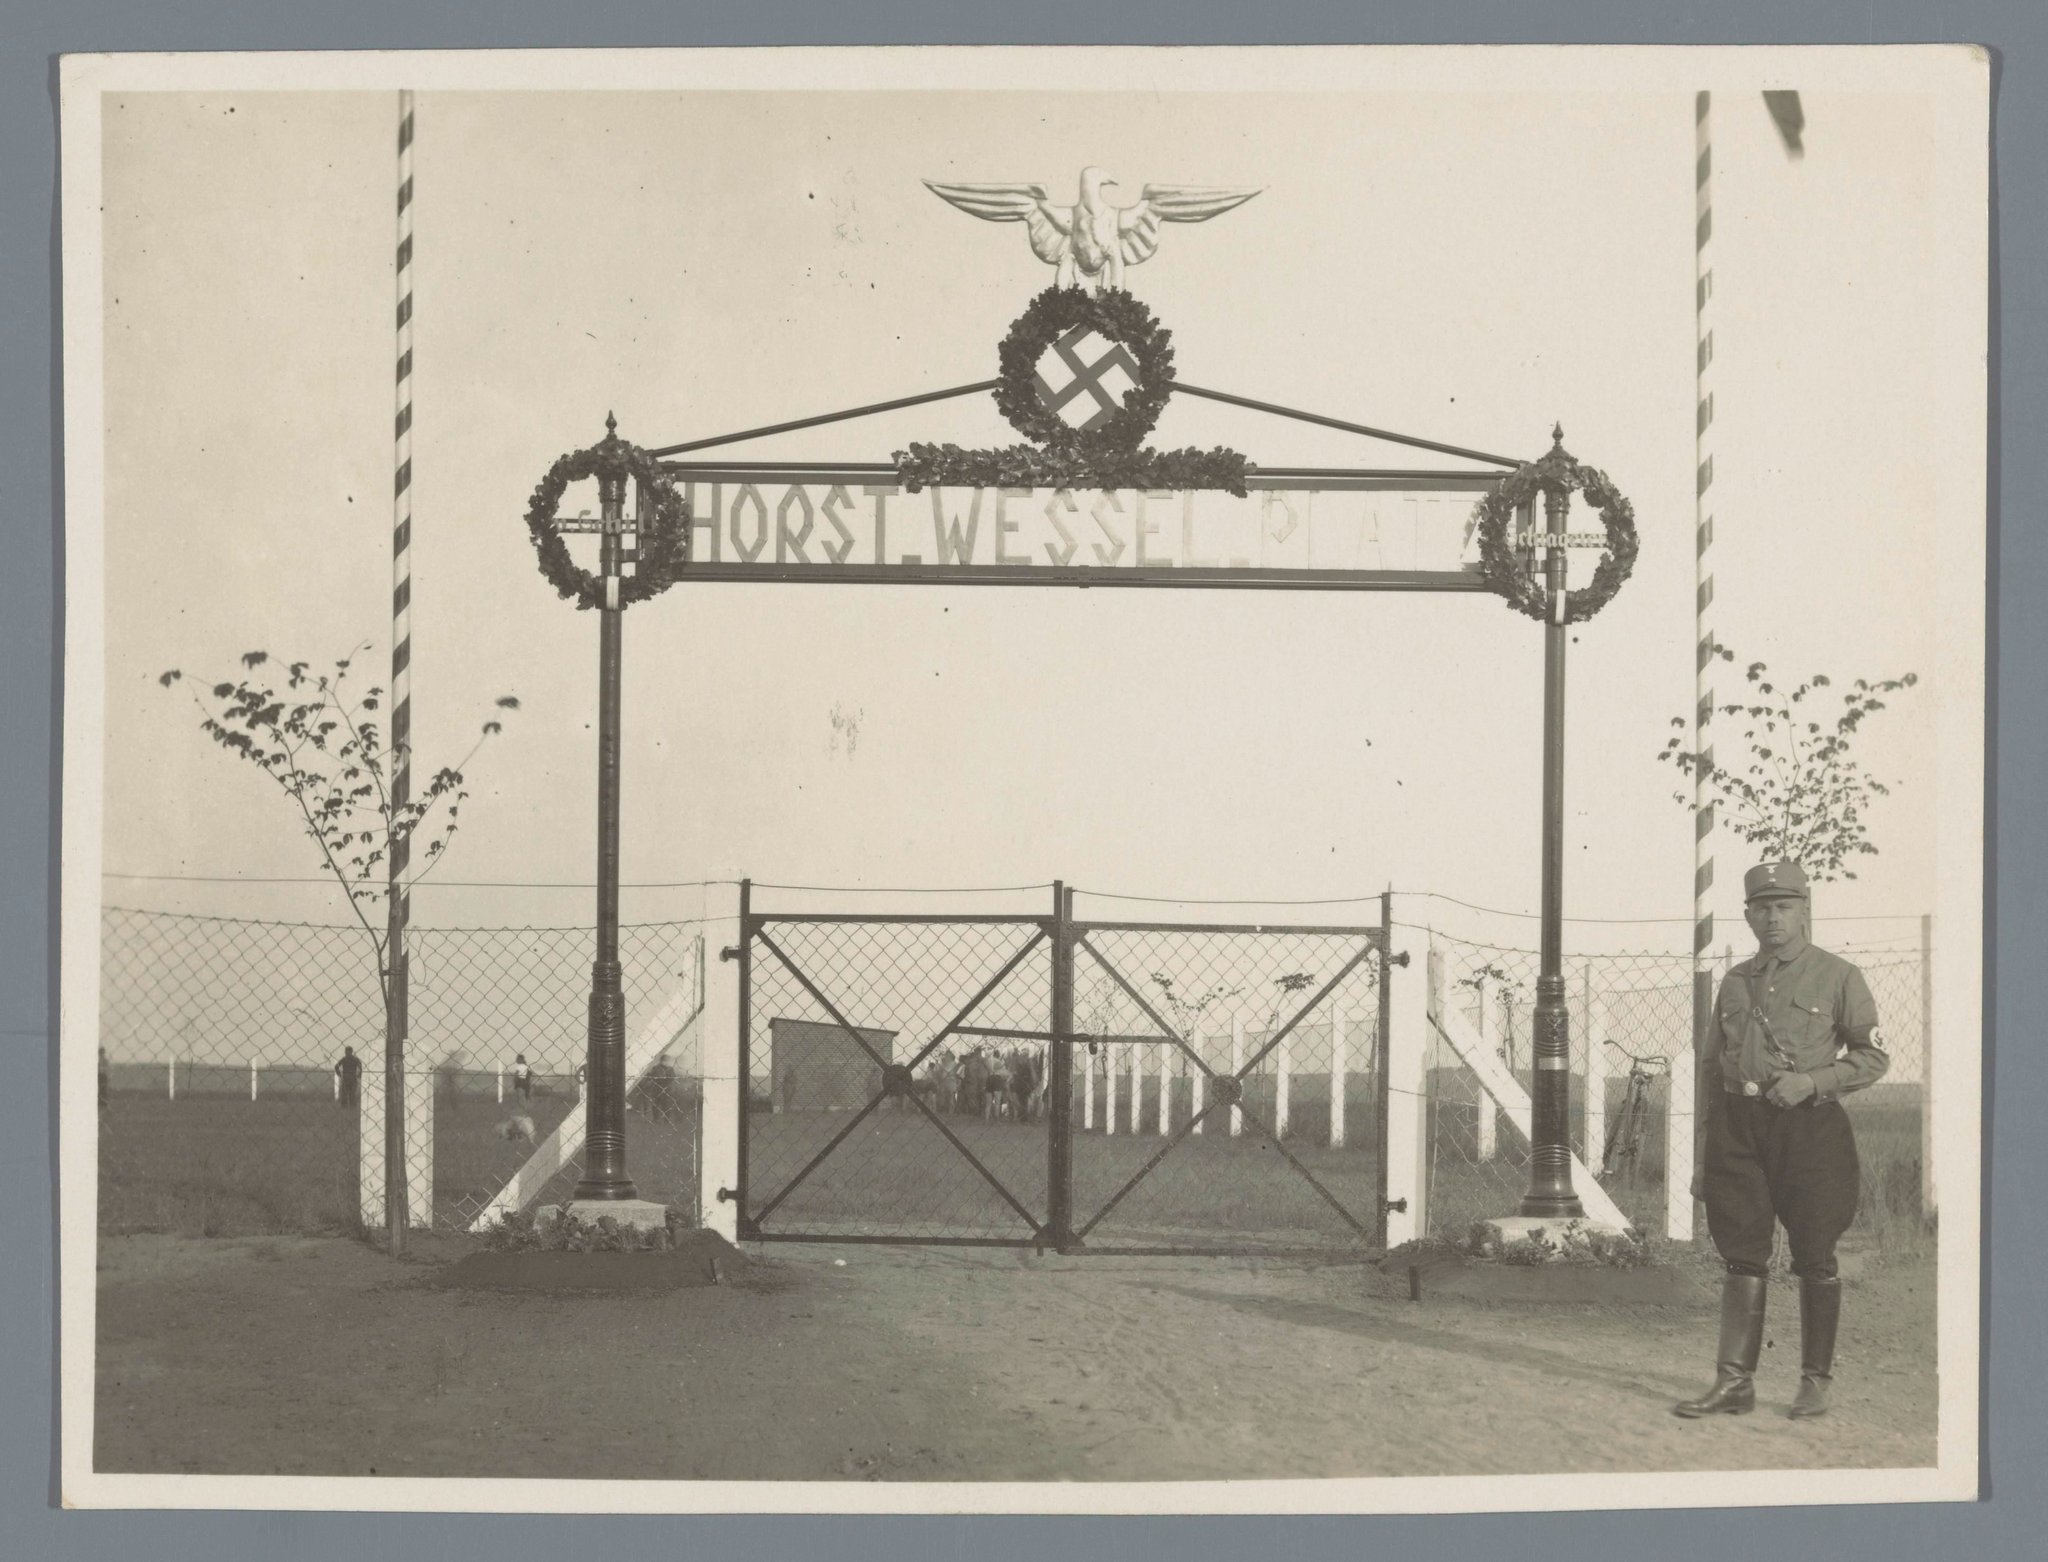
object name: photograph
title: Omheining van de Horst-Wessel-Platz (vermoedelijk) te Gartz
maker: Anonymous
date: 1933-1945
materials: photographic support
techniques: gelatin silver print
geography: gartz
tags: square, place, circus, etc., fence, wall, paling